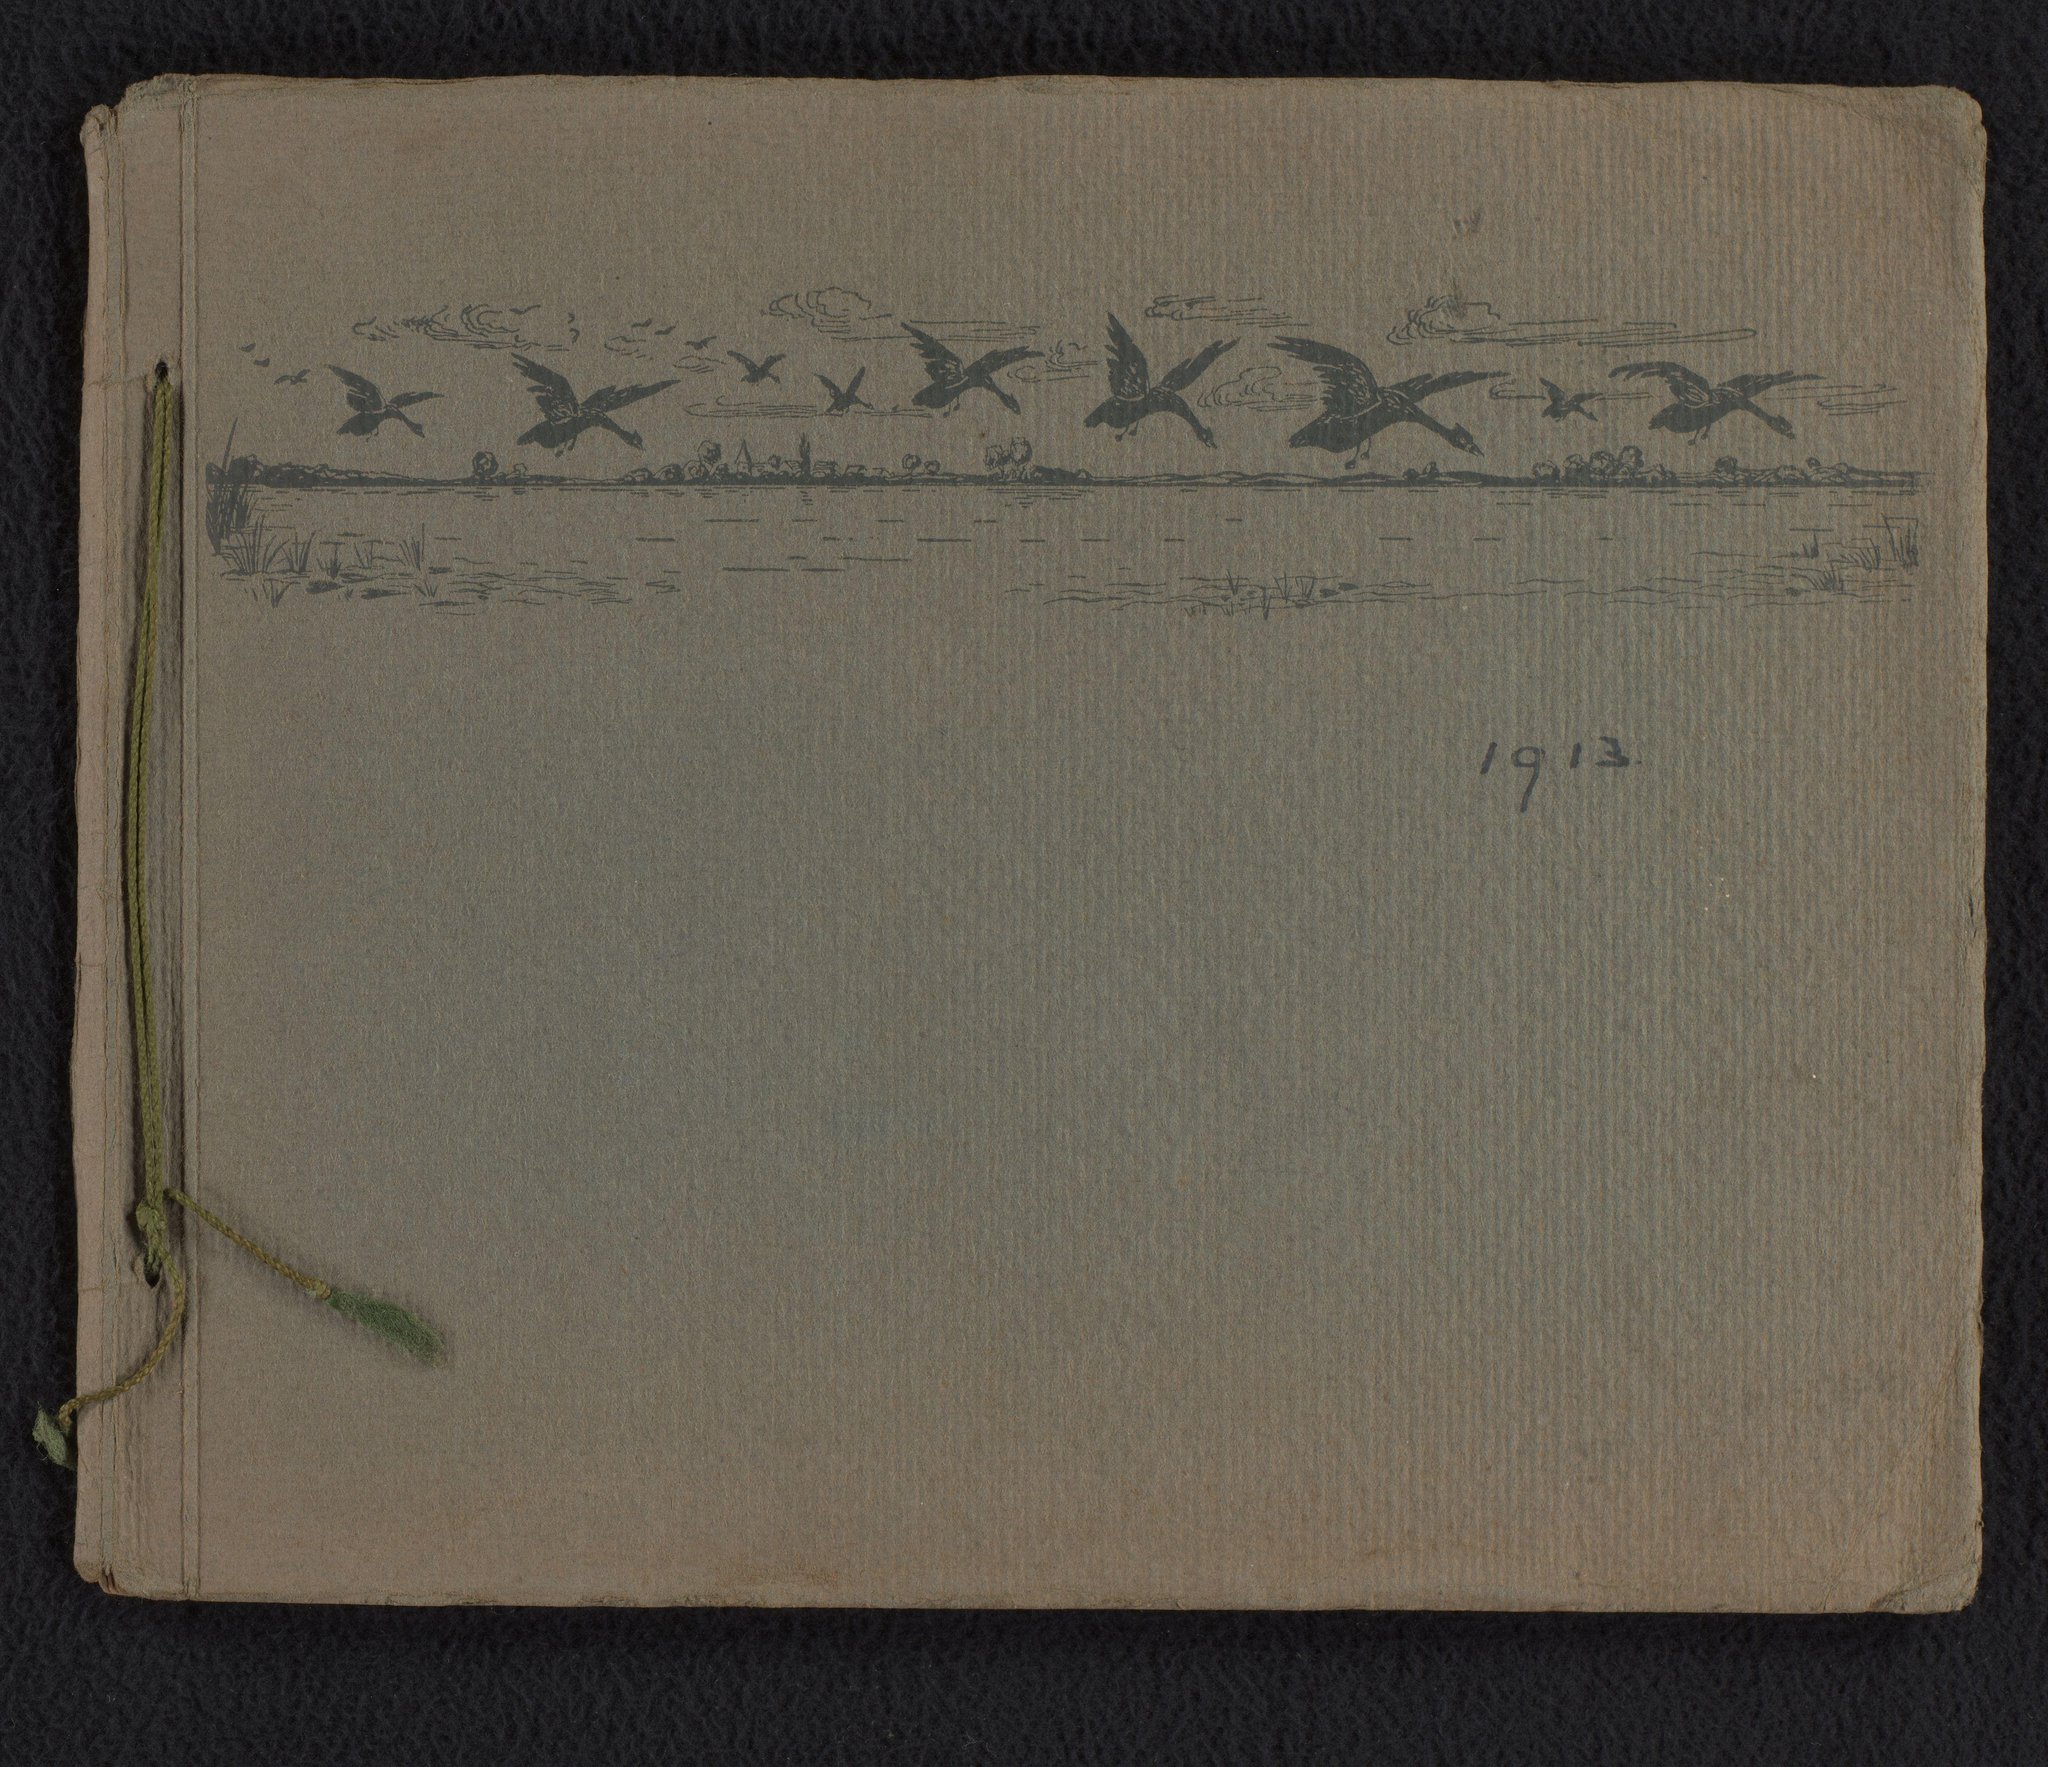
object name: photograph album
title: Fotoalbum van een lid van de familie Onnen-van den Berg met 126 foto's op 24 bladen.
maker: Anonymous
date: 1913-1914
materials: paper, cardboard, fiber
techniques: gelatin silver print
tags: emilie albertina onnen (milly), tennis, lawn-tennis, family life, batavia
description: Fotoalbum van een lid van de familie Onnen-van den Berg met 126 foto's op 24 bladen.